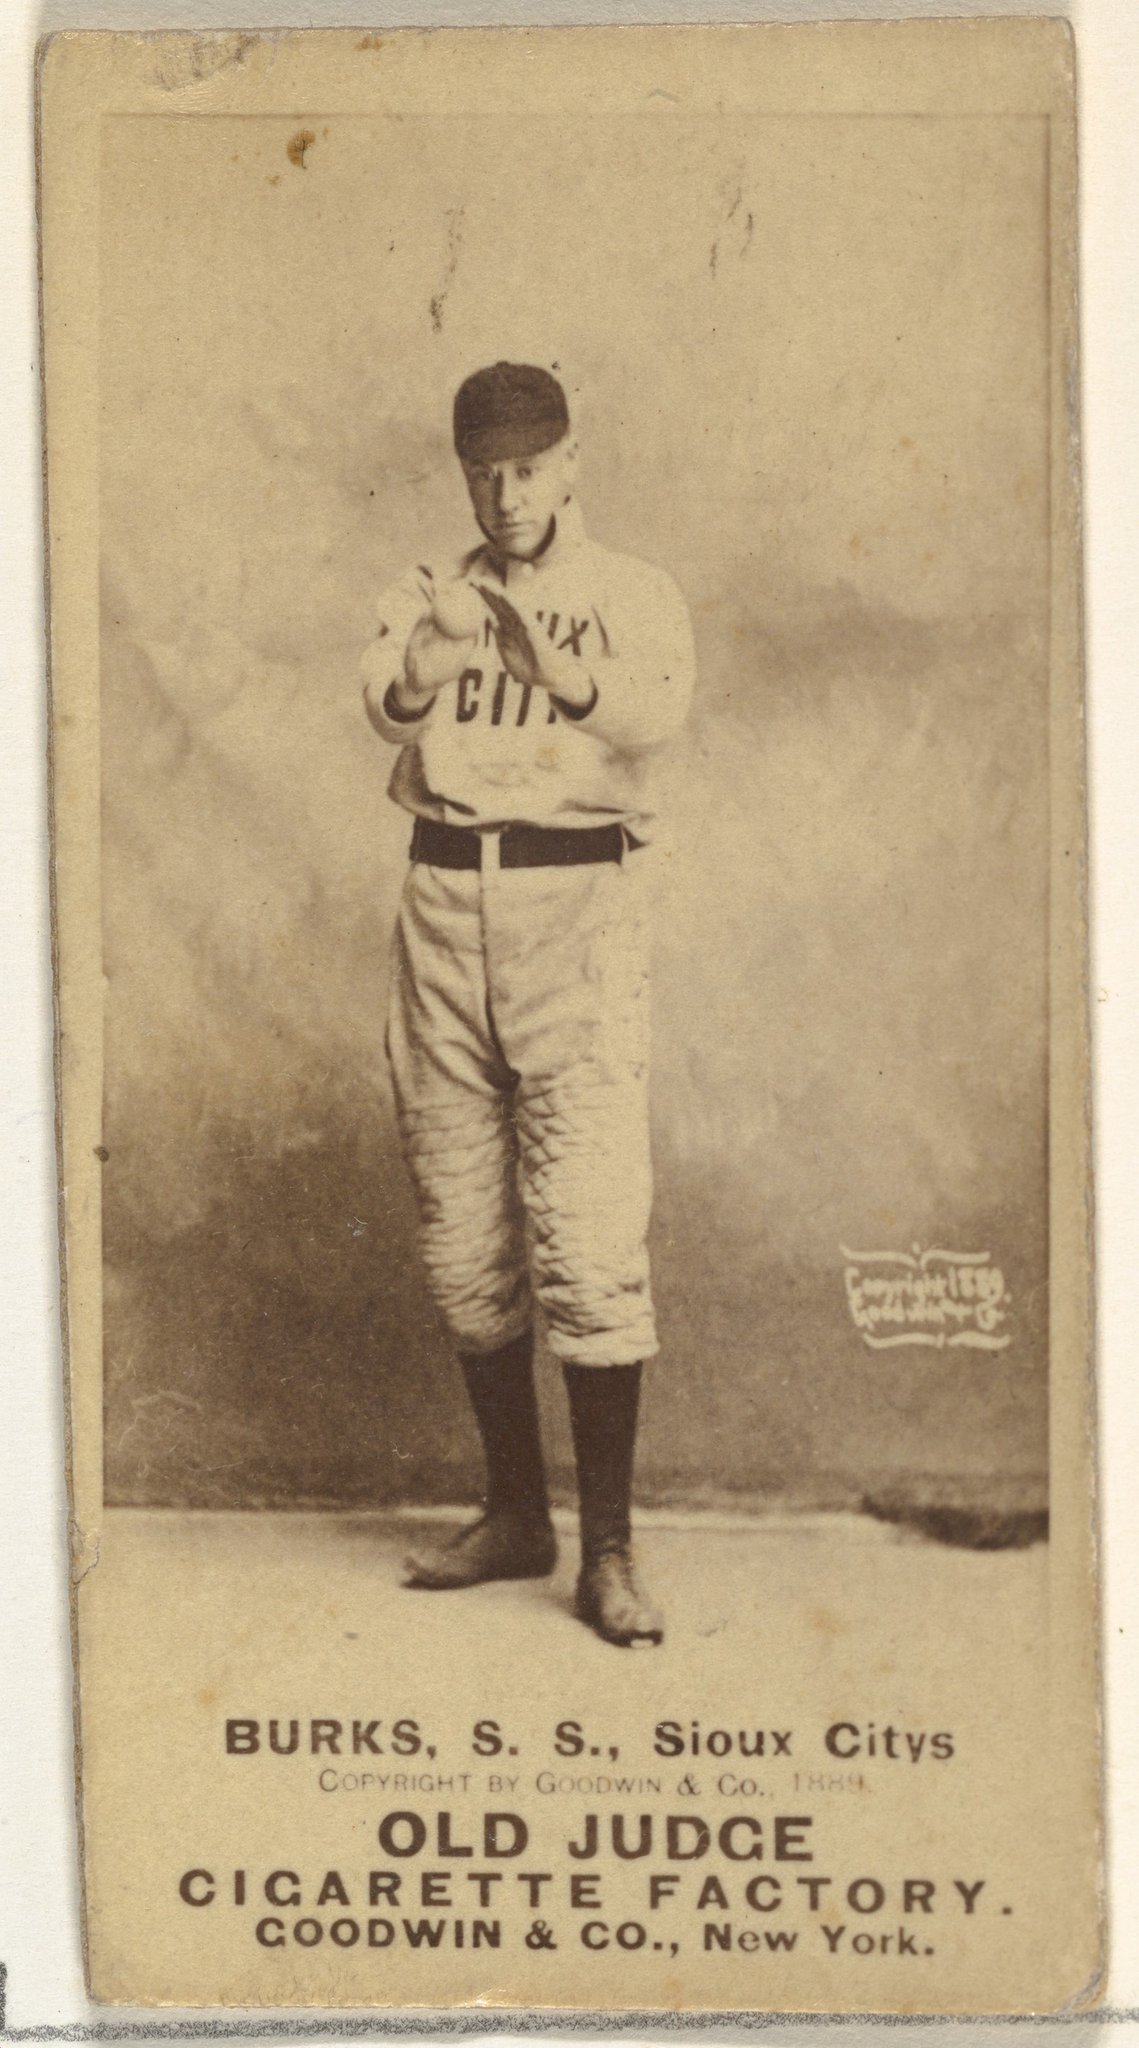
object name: baseball card, photograph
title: Robert E. Burks, Shortstop, Sioux City Corn Huskers, from the Old Judge series (N172) for Old Judge Cigarettes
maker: goodwin & company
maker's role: publisher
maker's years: 1850-1950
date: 1889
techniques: albumen silver print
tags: men,portraits,baseball,athletes